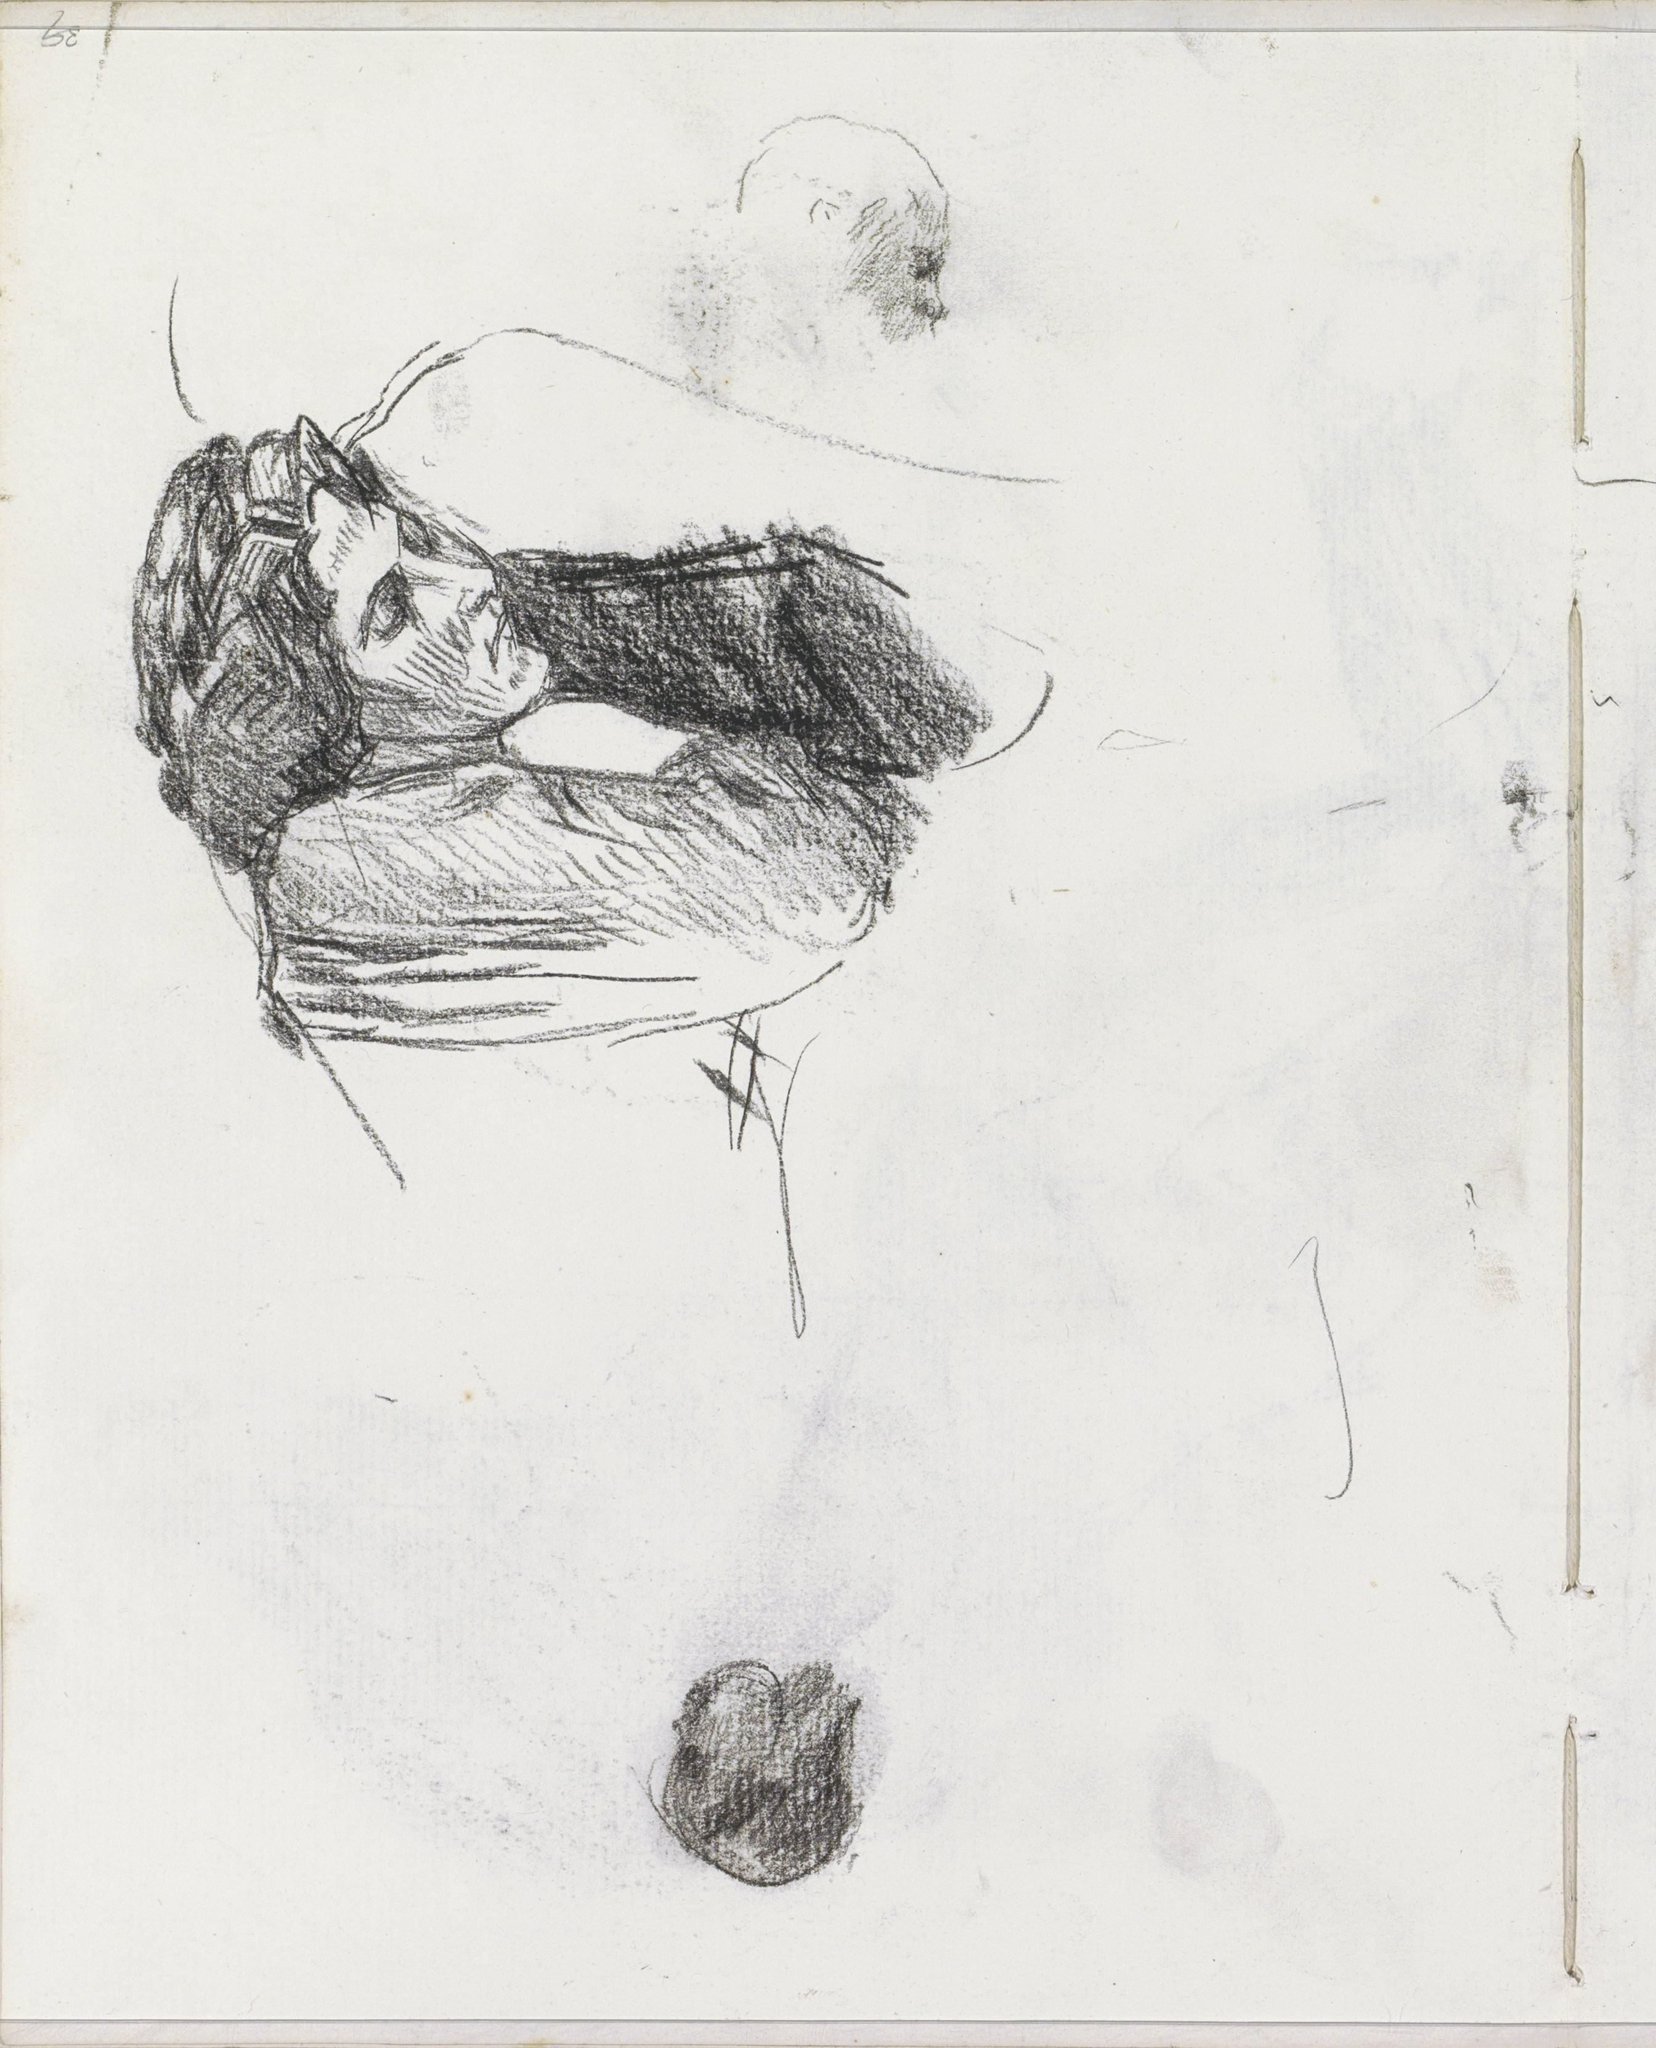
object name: sketchbook leaf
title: Vrouw met gesloten ogen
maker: isaac israels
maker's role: draughtsman, painter, print maker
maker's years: 1865-1934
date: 1875-1934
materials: chalk, paper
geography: the hague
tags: adult woman, child, eyes closed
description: Ze steunt op haar armen. Verder twee kinderhoofden. Blad 12 verso uit schetsboek XIII met 25 bladen.